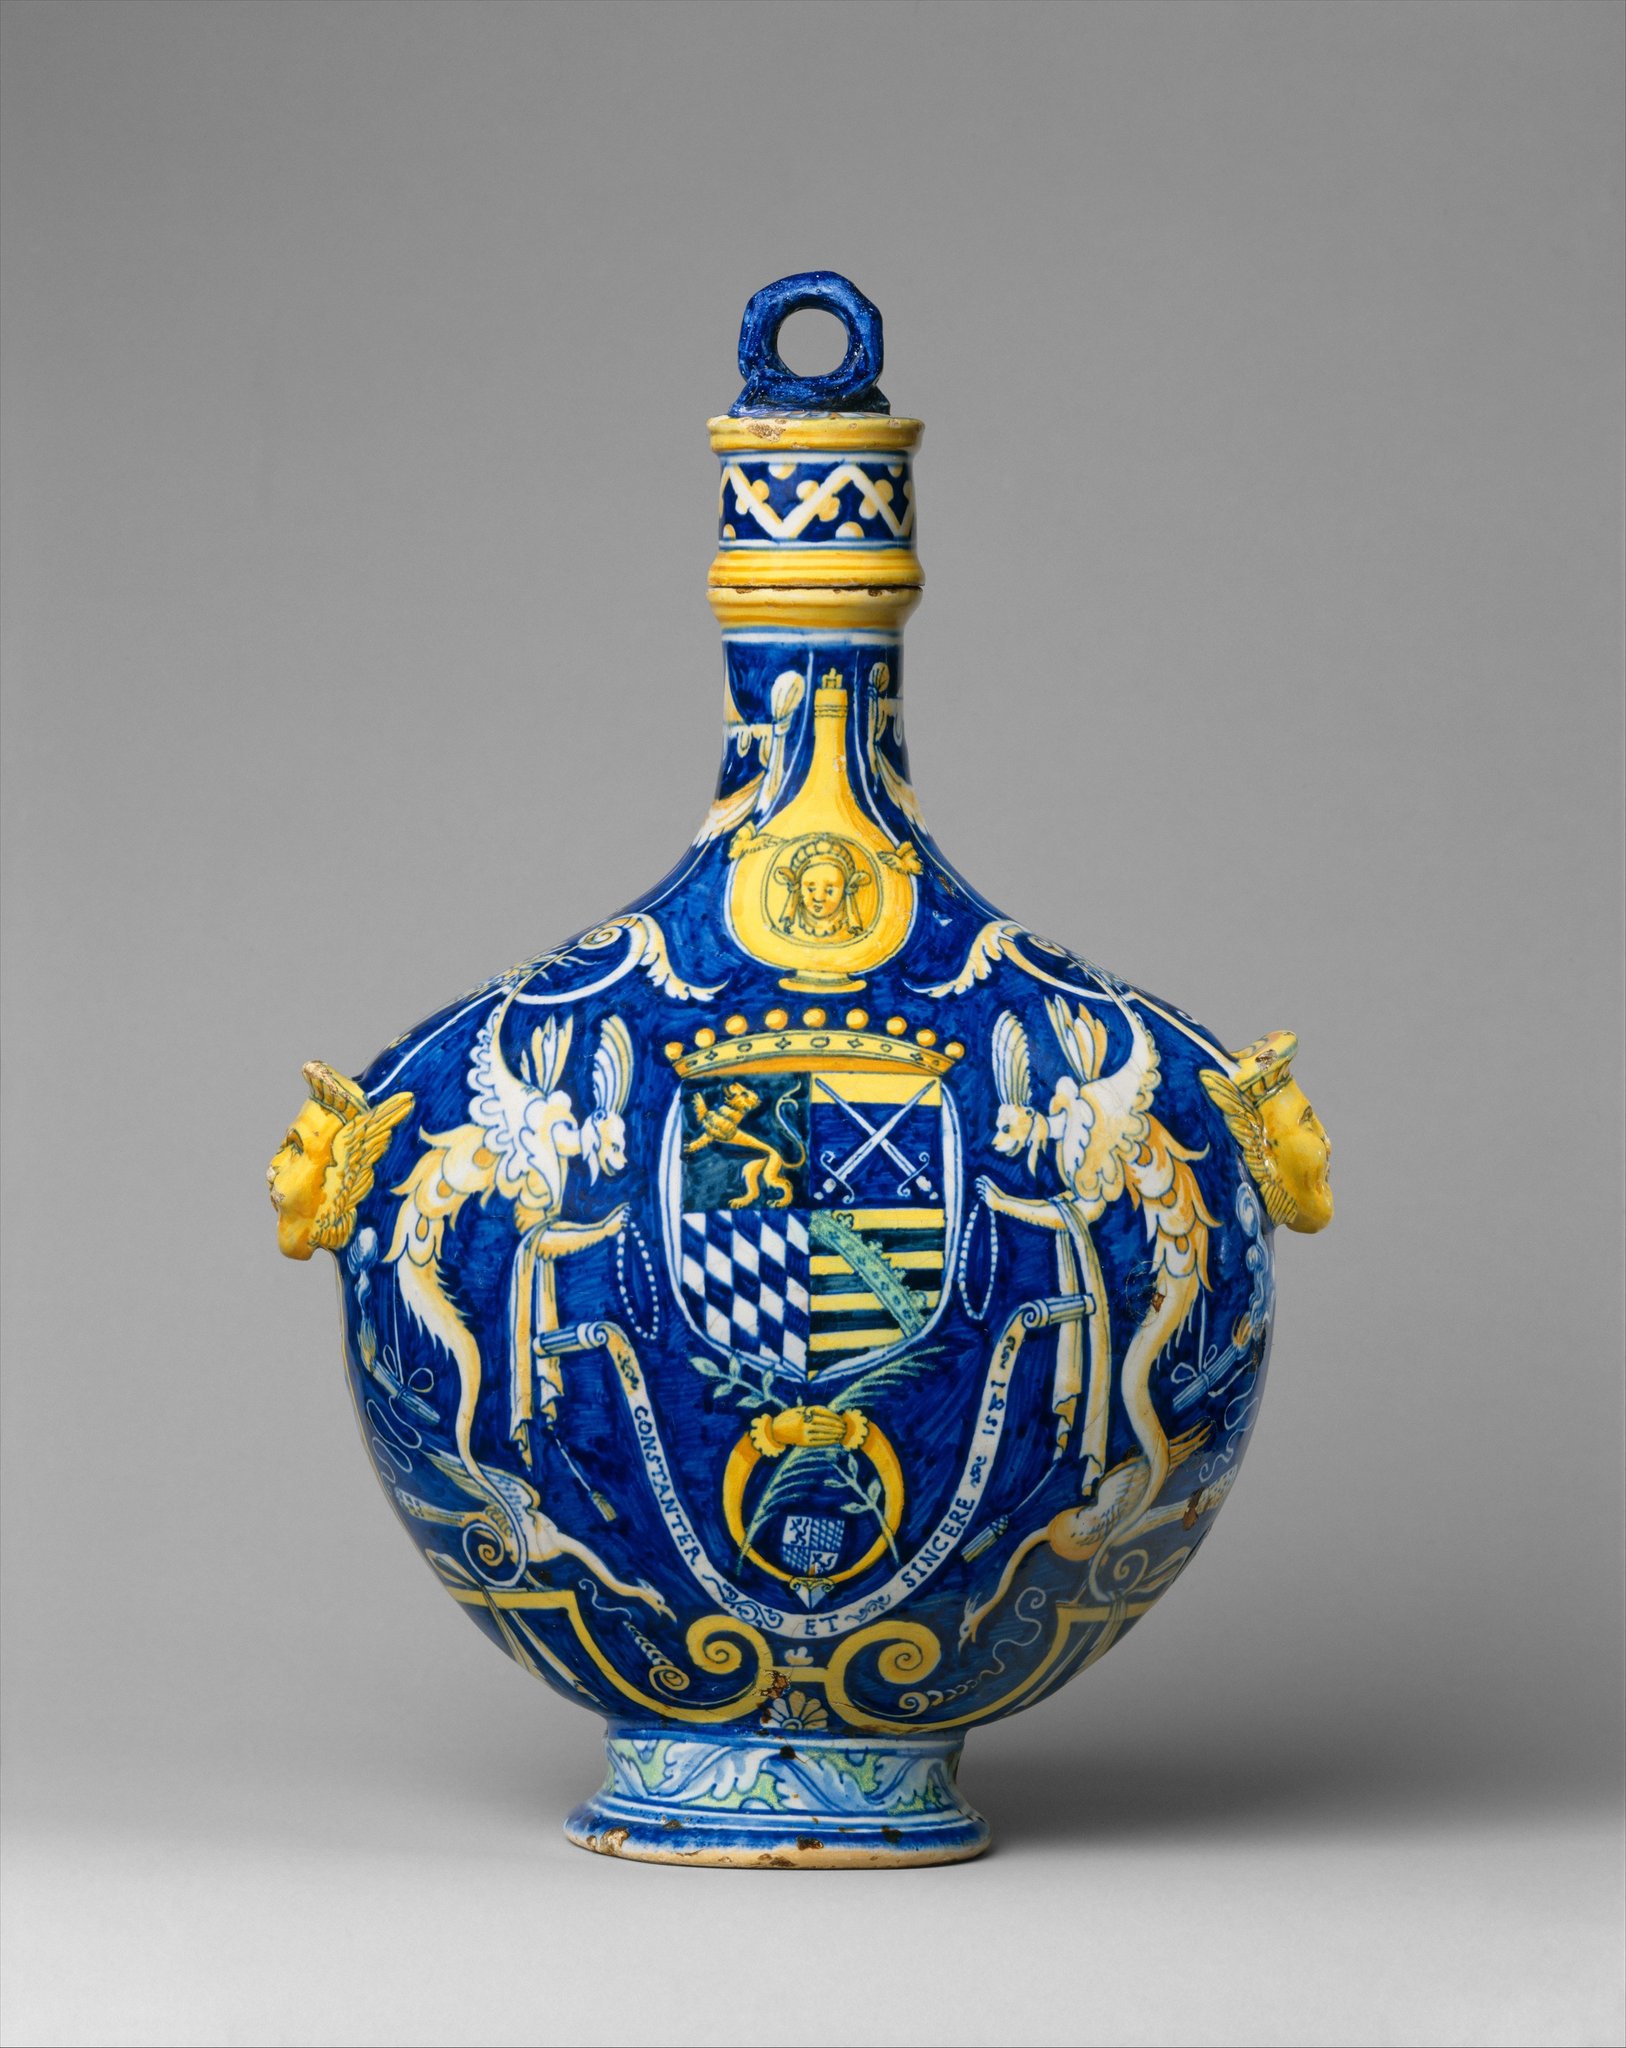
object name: pilgrim bottle with screw top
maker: antoine syjalon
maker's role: maker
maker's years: 1524-1590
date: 1581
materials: earthenware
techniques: glazing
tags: birds,masks,mythical creatures,coat of arms